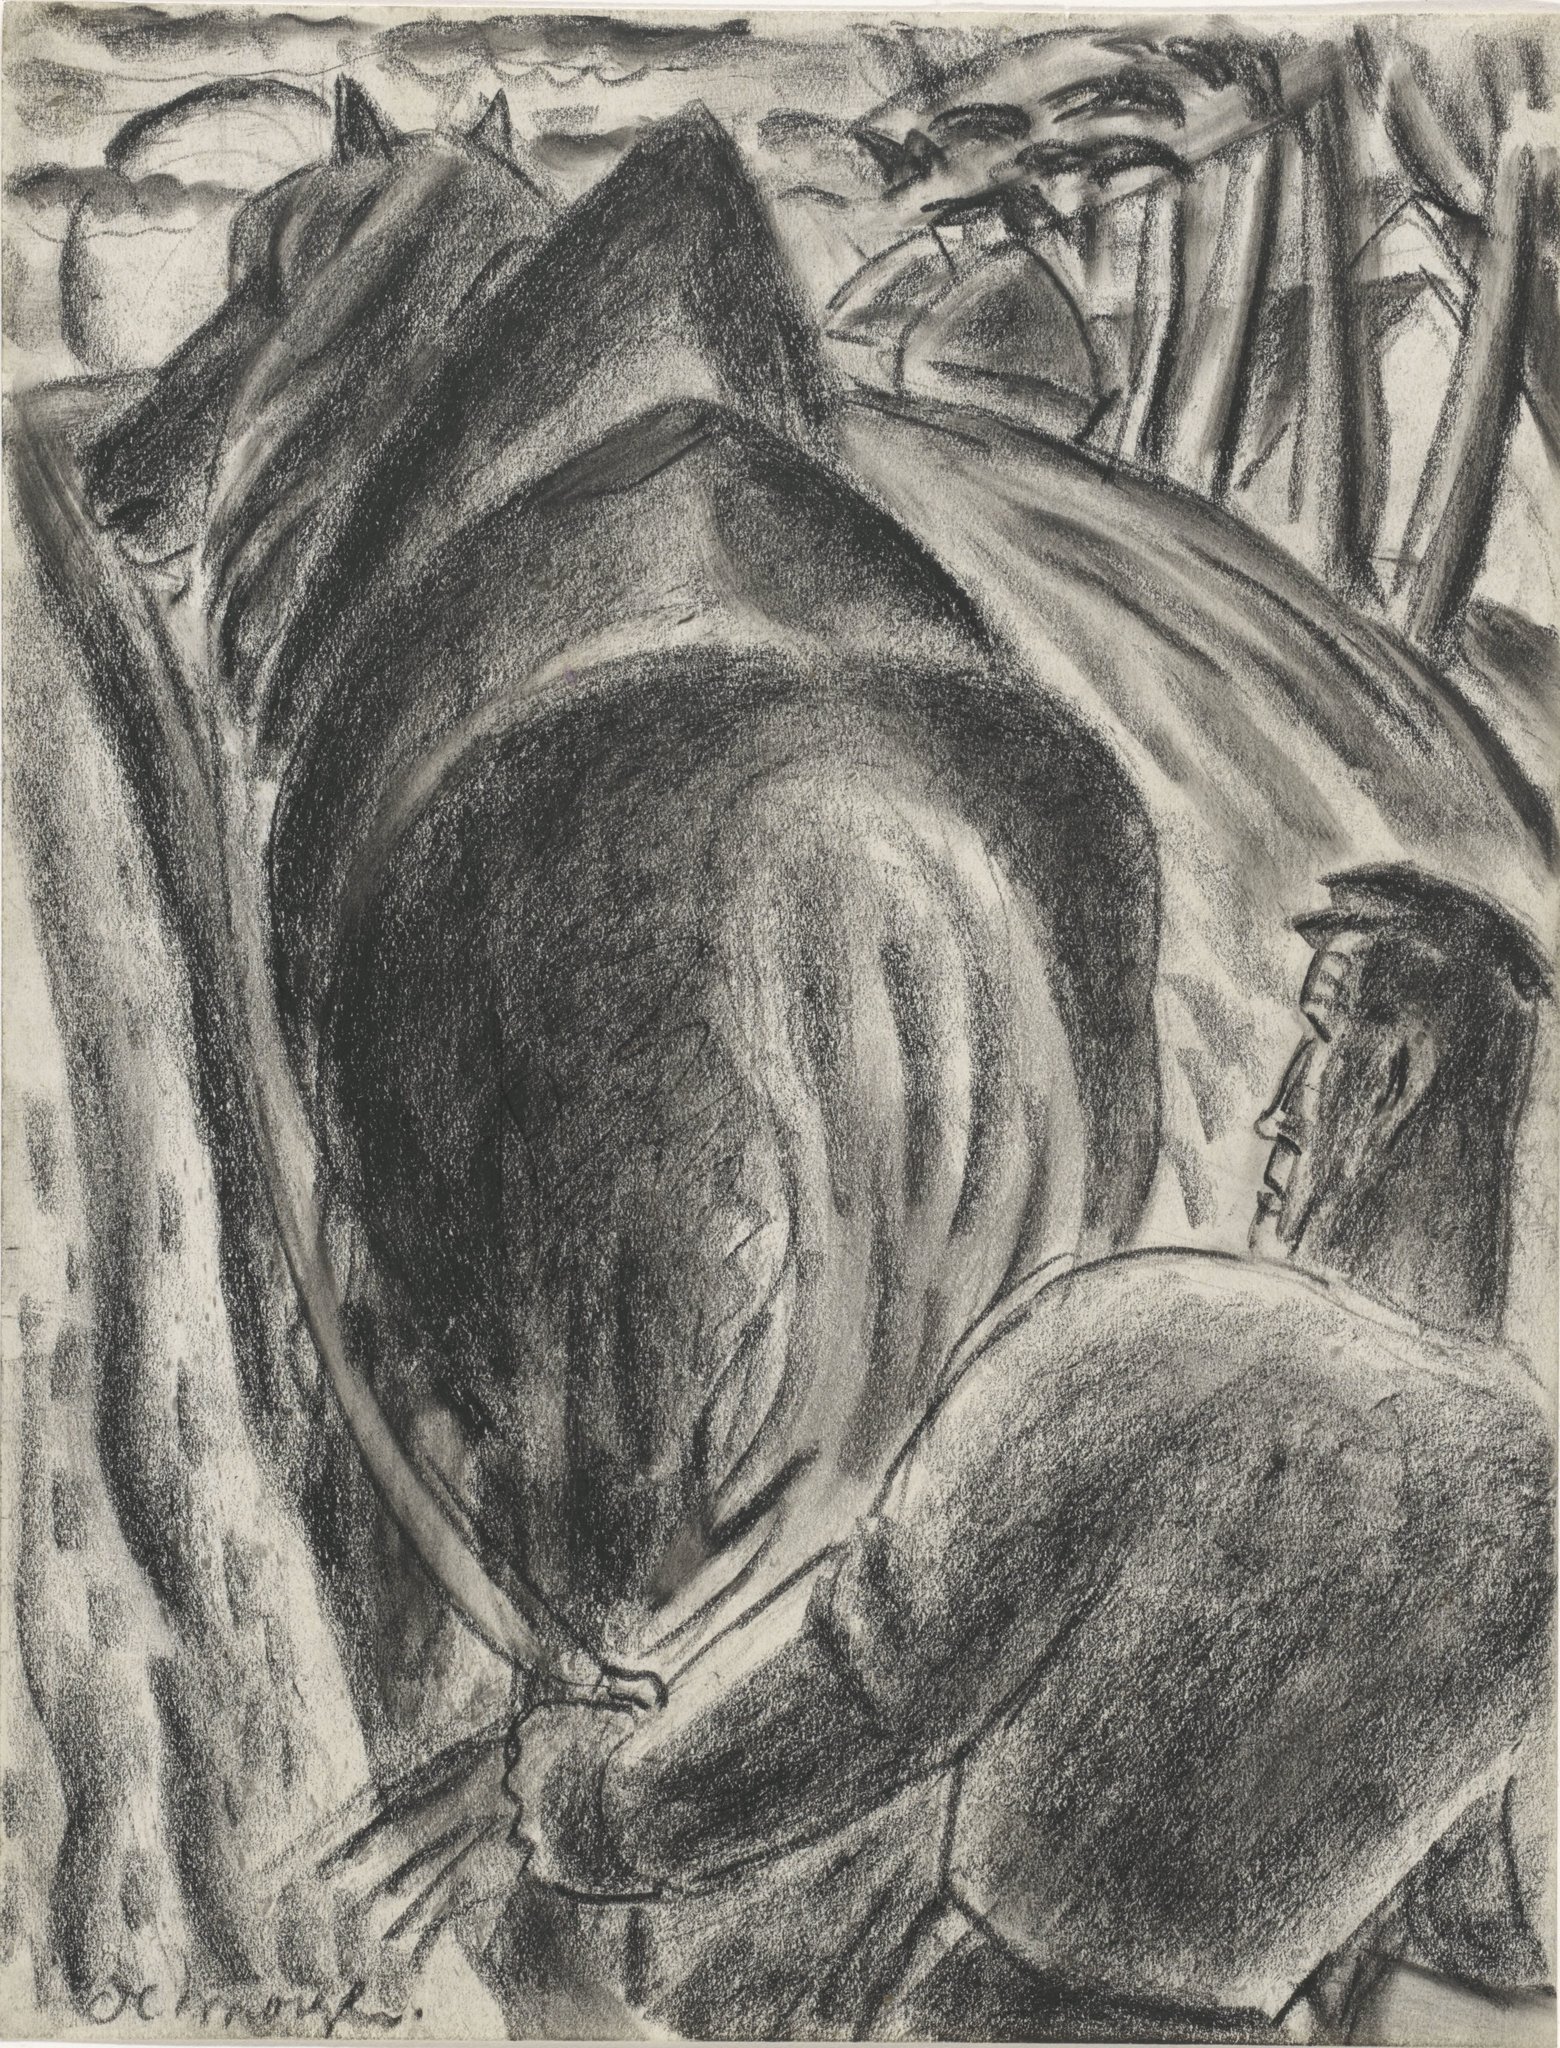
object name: drawing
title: De morgen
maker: leo gestel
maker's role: draughtsman, print maker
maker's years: 1881-1941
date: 1927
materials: charcoal, paper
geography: belgium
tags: ploughing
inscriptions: title: ‘de morgen’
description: Boer met ploeg (gereedschap onzichtbaar) achter trekpaard op de rug gezien.